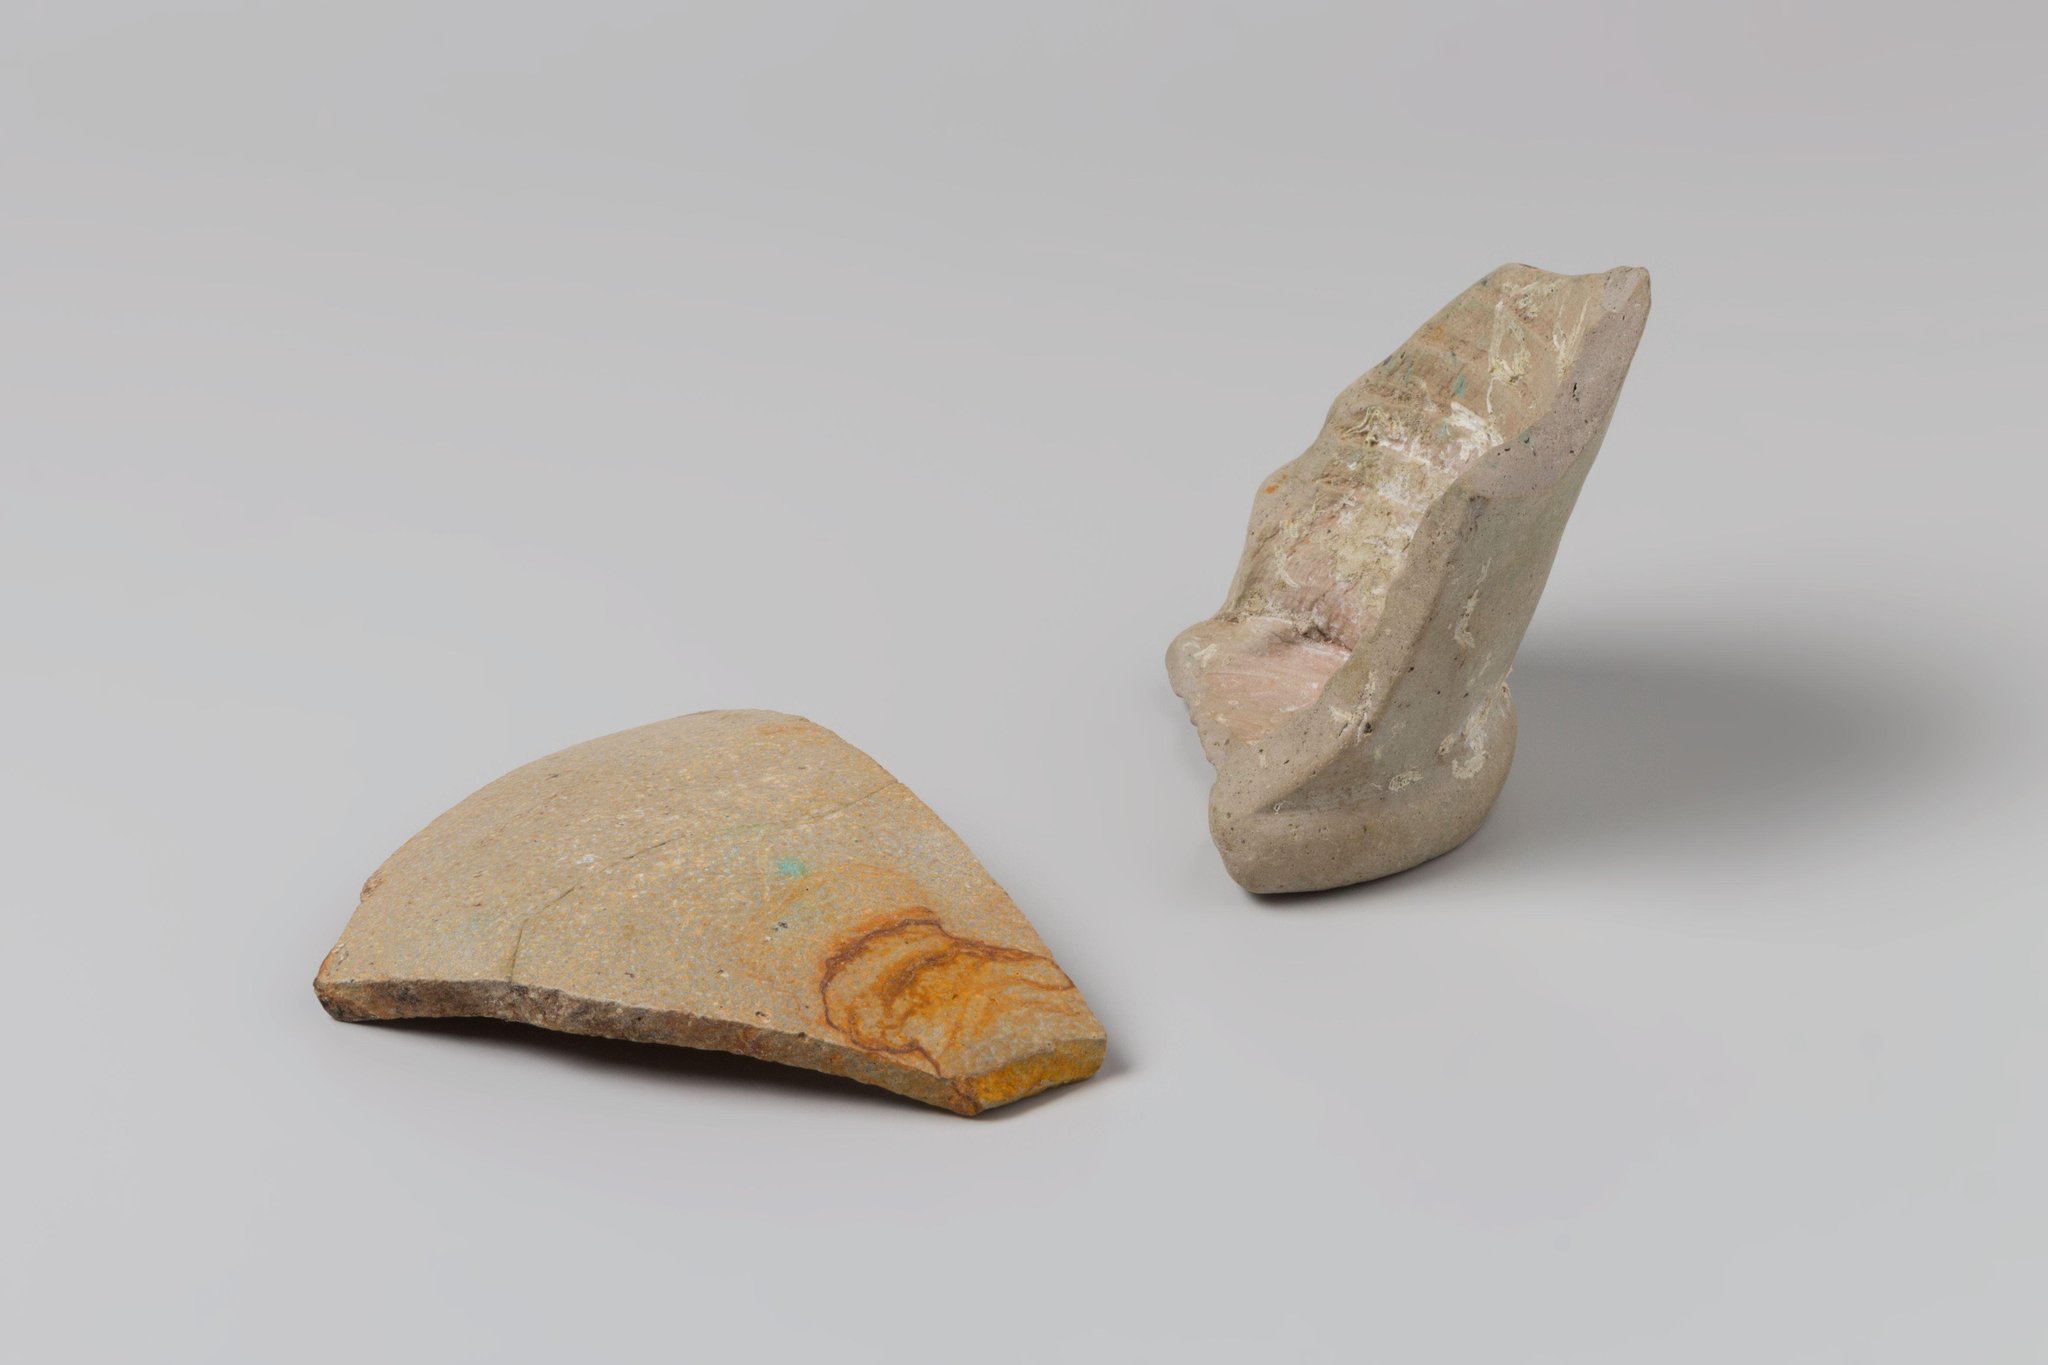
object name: sherd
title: Scherven van een kan uit het wrak van de Oost-Indiëvaarder Hollandia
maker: Anonymous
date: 1700-1743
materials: stoneware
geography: westerwald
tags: verenigde oostindische compagnie, hollandia (schip), annet